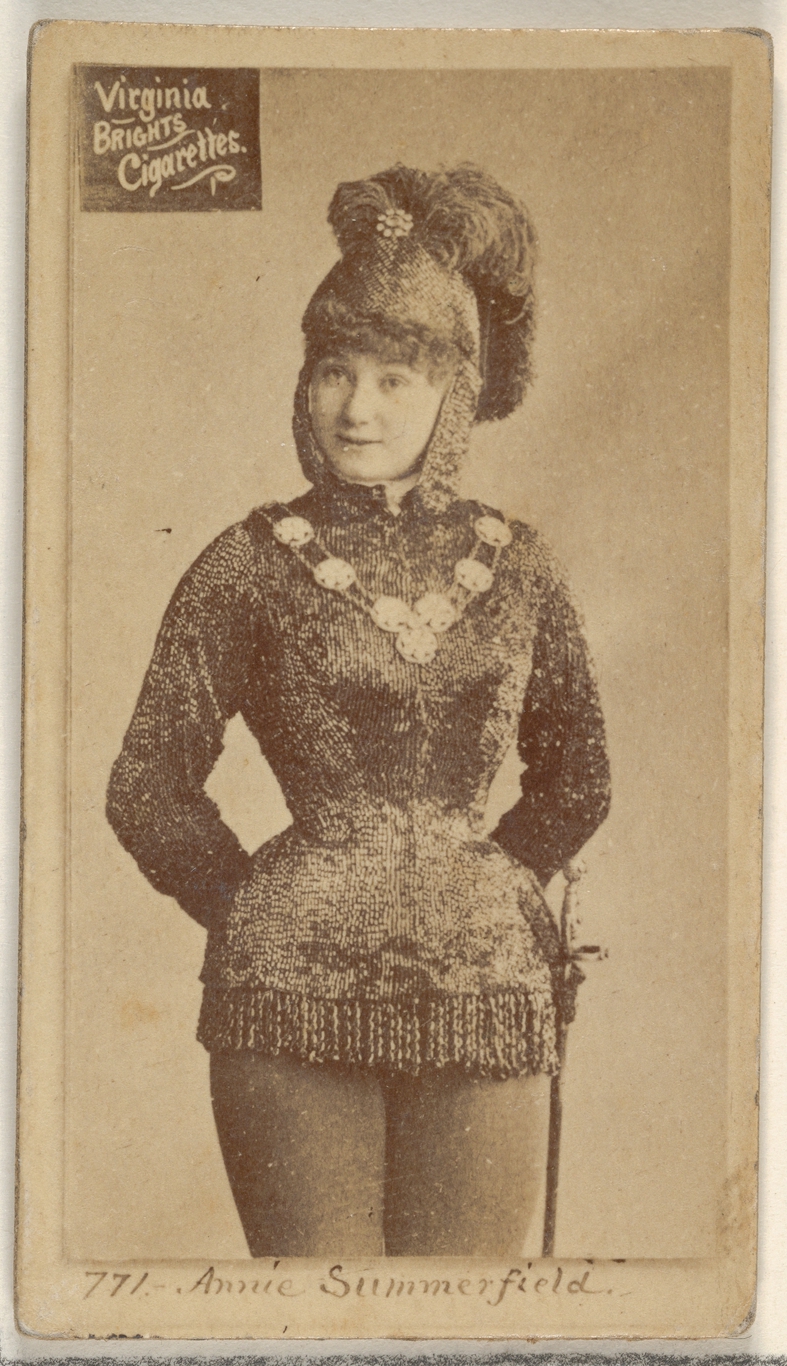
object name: photograph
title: Card 771, Annie Summerfield, from the Actors and Actresses series (N45, Type 2) for Virginia Brights Cigarettes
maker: allen & ginter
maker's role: publisher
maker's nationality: american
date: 1888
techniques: albumen silver print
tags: portraits,women,actresses